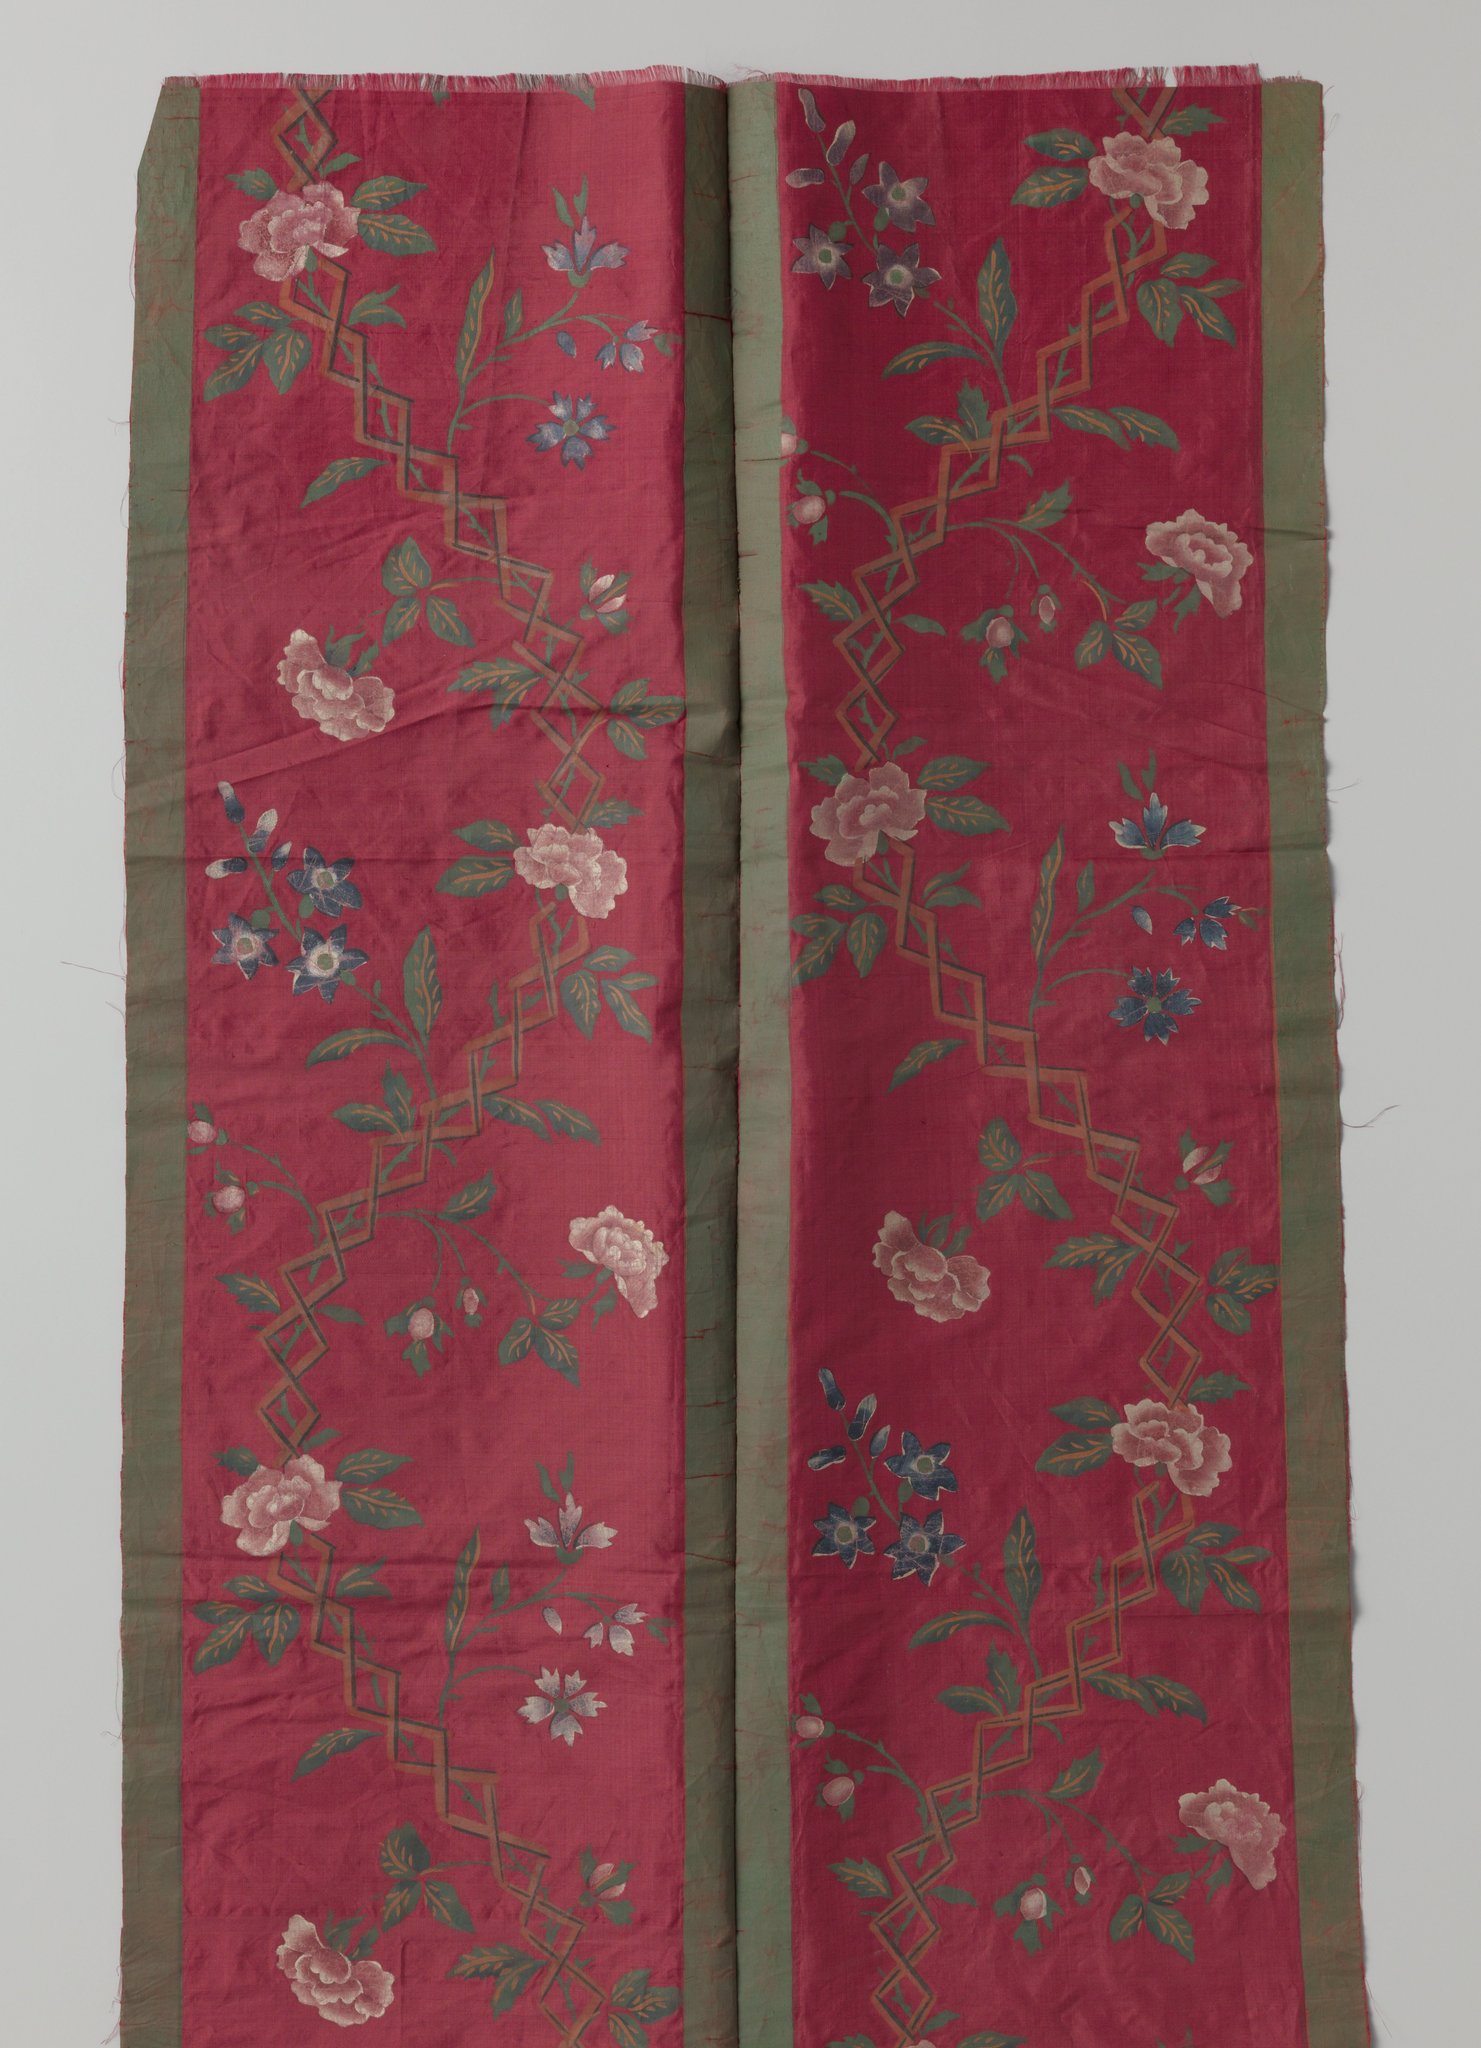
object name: upholstered wall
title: Fragment van een wandbespanning van beschilderde en bedrukte rode zijde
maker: Anonymous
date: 1770-1780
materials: silk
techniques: printing, weave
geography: netherlands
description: Fragment van rode zijde beschilderd met bloemen en bladeren in geel, blauw, wit en groen.